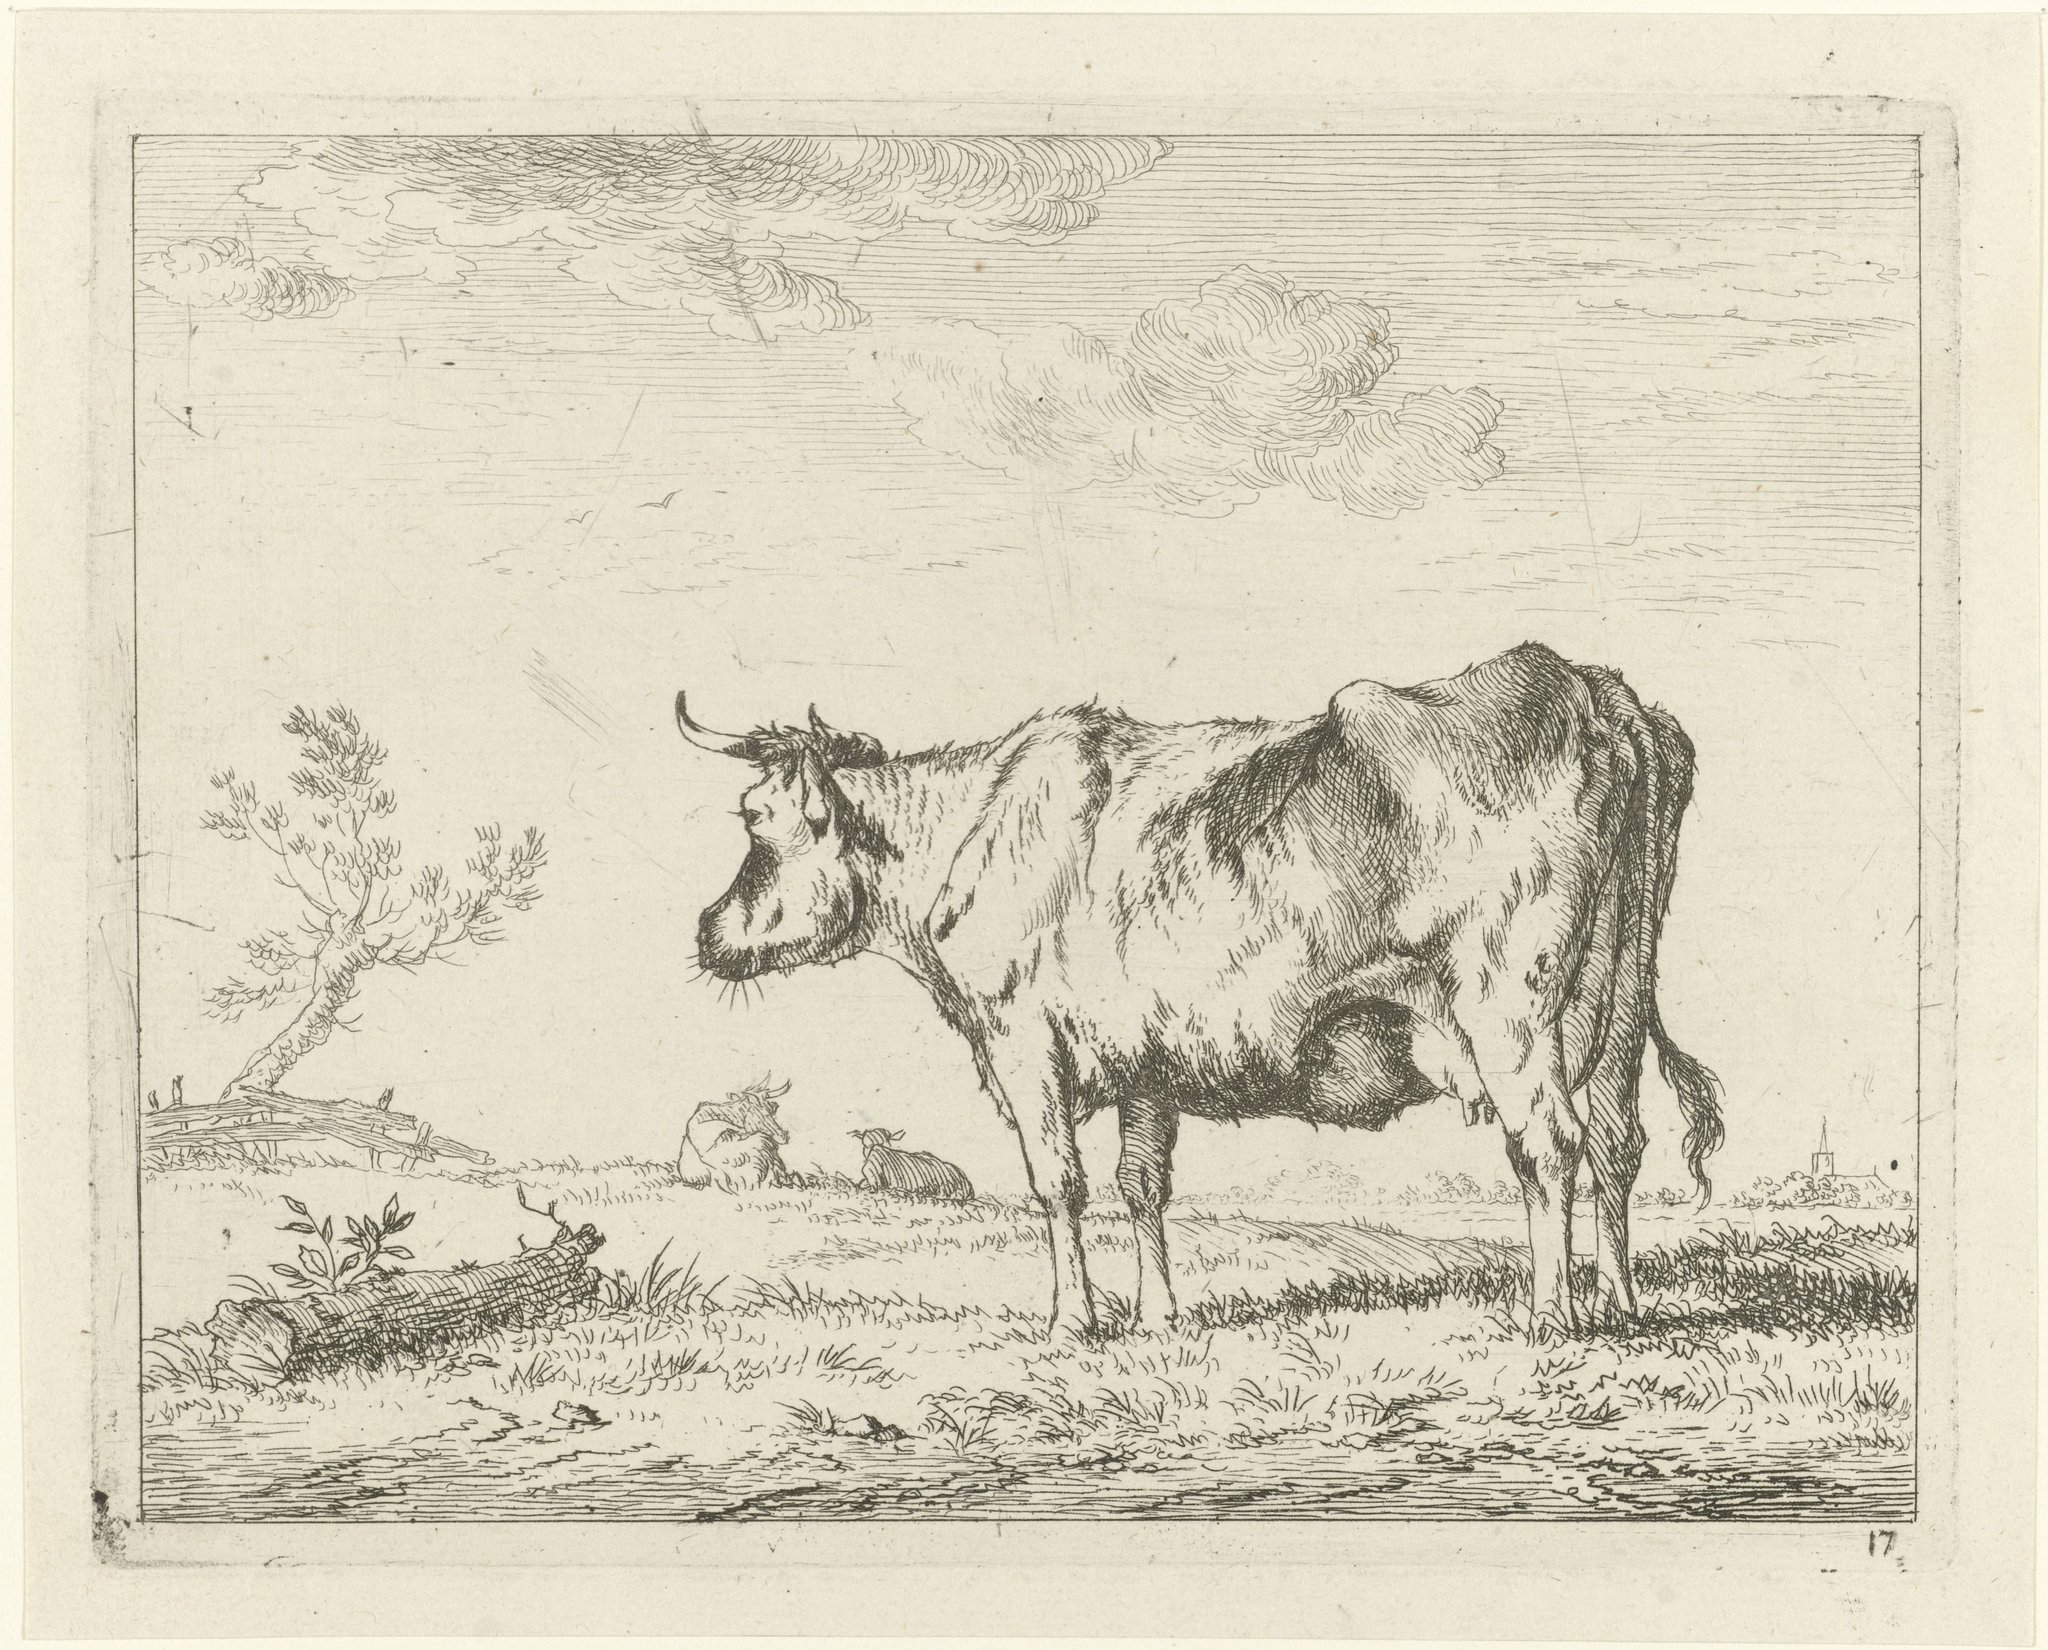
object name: print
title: Weiland met staande koe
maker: johannes janson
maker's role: draughtsman, painter, print maker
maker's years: 1729-1784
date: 1761-1784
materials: paper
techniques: etching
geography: leiden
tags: cow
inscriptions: collector's mark: Lugt 2228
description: Weiland met staande koe, van opzij gezien. Op de achtergrond twee liggende koeien. Rechtsonder: 17. Prent uit een serie met landschappen met vee.